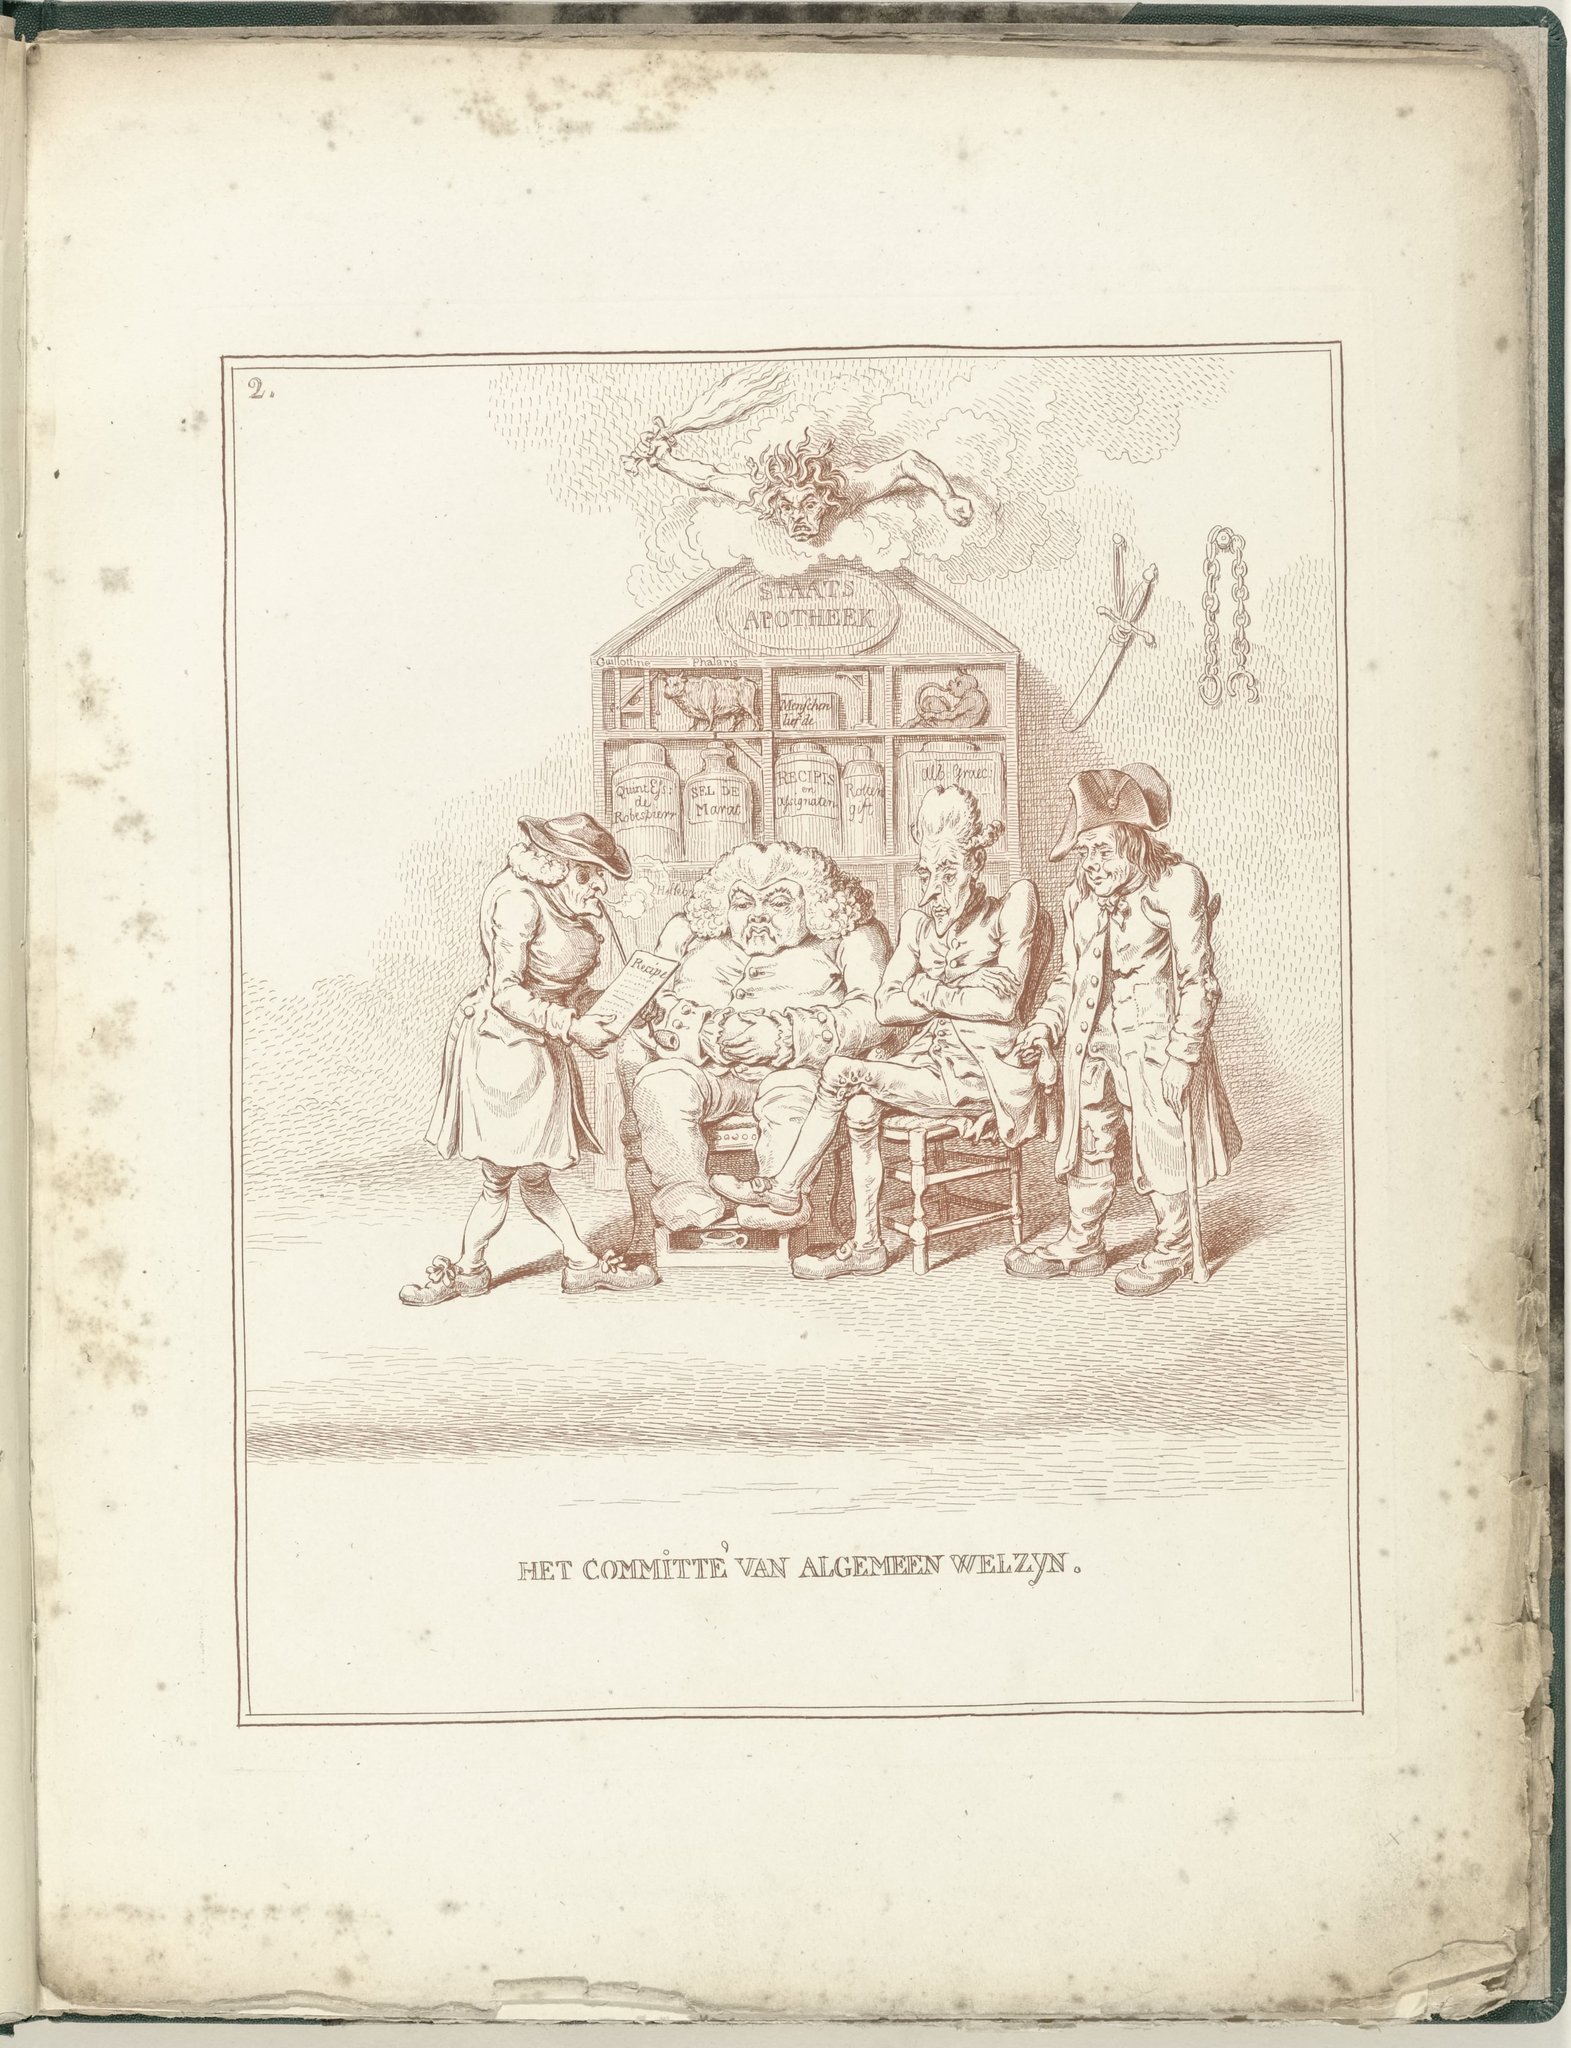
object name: cartoon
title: Het Committé van Algemeen Welzyn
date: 1795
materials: paper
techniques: etching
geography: london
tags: amsterdam, person with a physical disability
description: Onderdeel van een in boekvorm uitgegeven serie van twintig spotprenten op de Provisionele Representanten van het Volk van Holland en de Bataafse Republiek in het algemeen in het jaar 1795. De serietitel 'Hollandia Regenerata' staat vermeld op de titelprent. Elke prent gevolgd door een tekstblad met een Bijbelcitaat in het Nederlands, een verklaring in het Frans en het Bijbelcitaat in het Engels. Waarschijnlijk uitgegeven in Londen door William Humphrey in 1795.